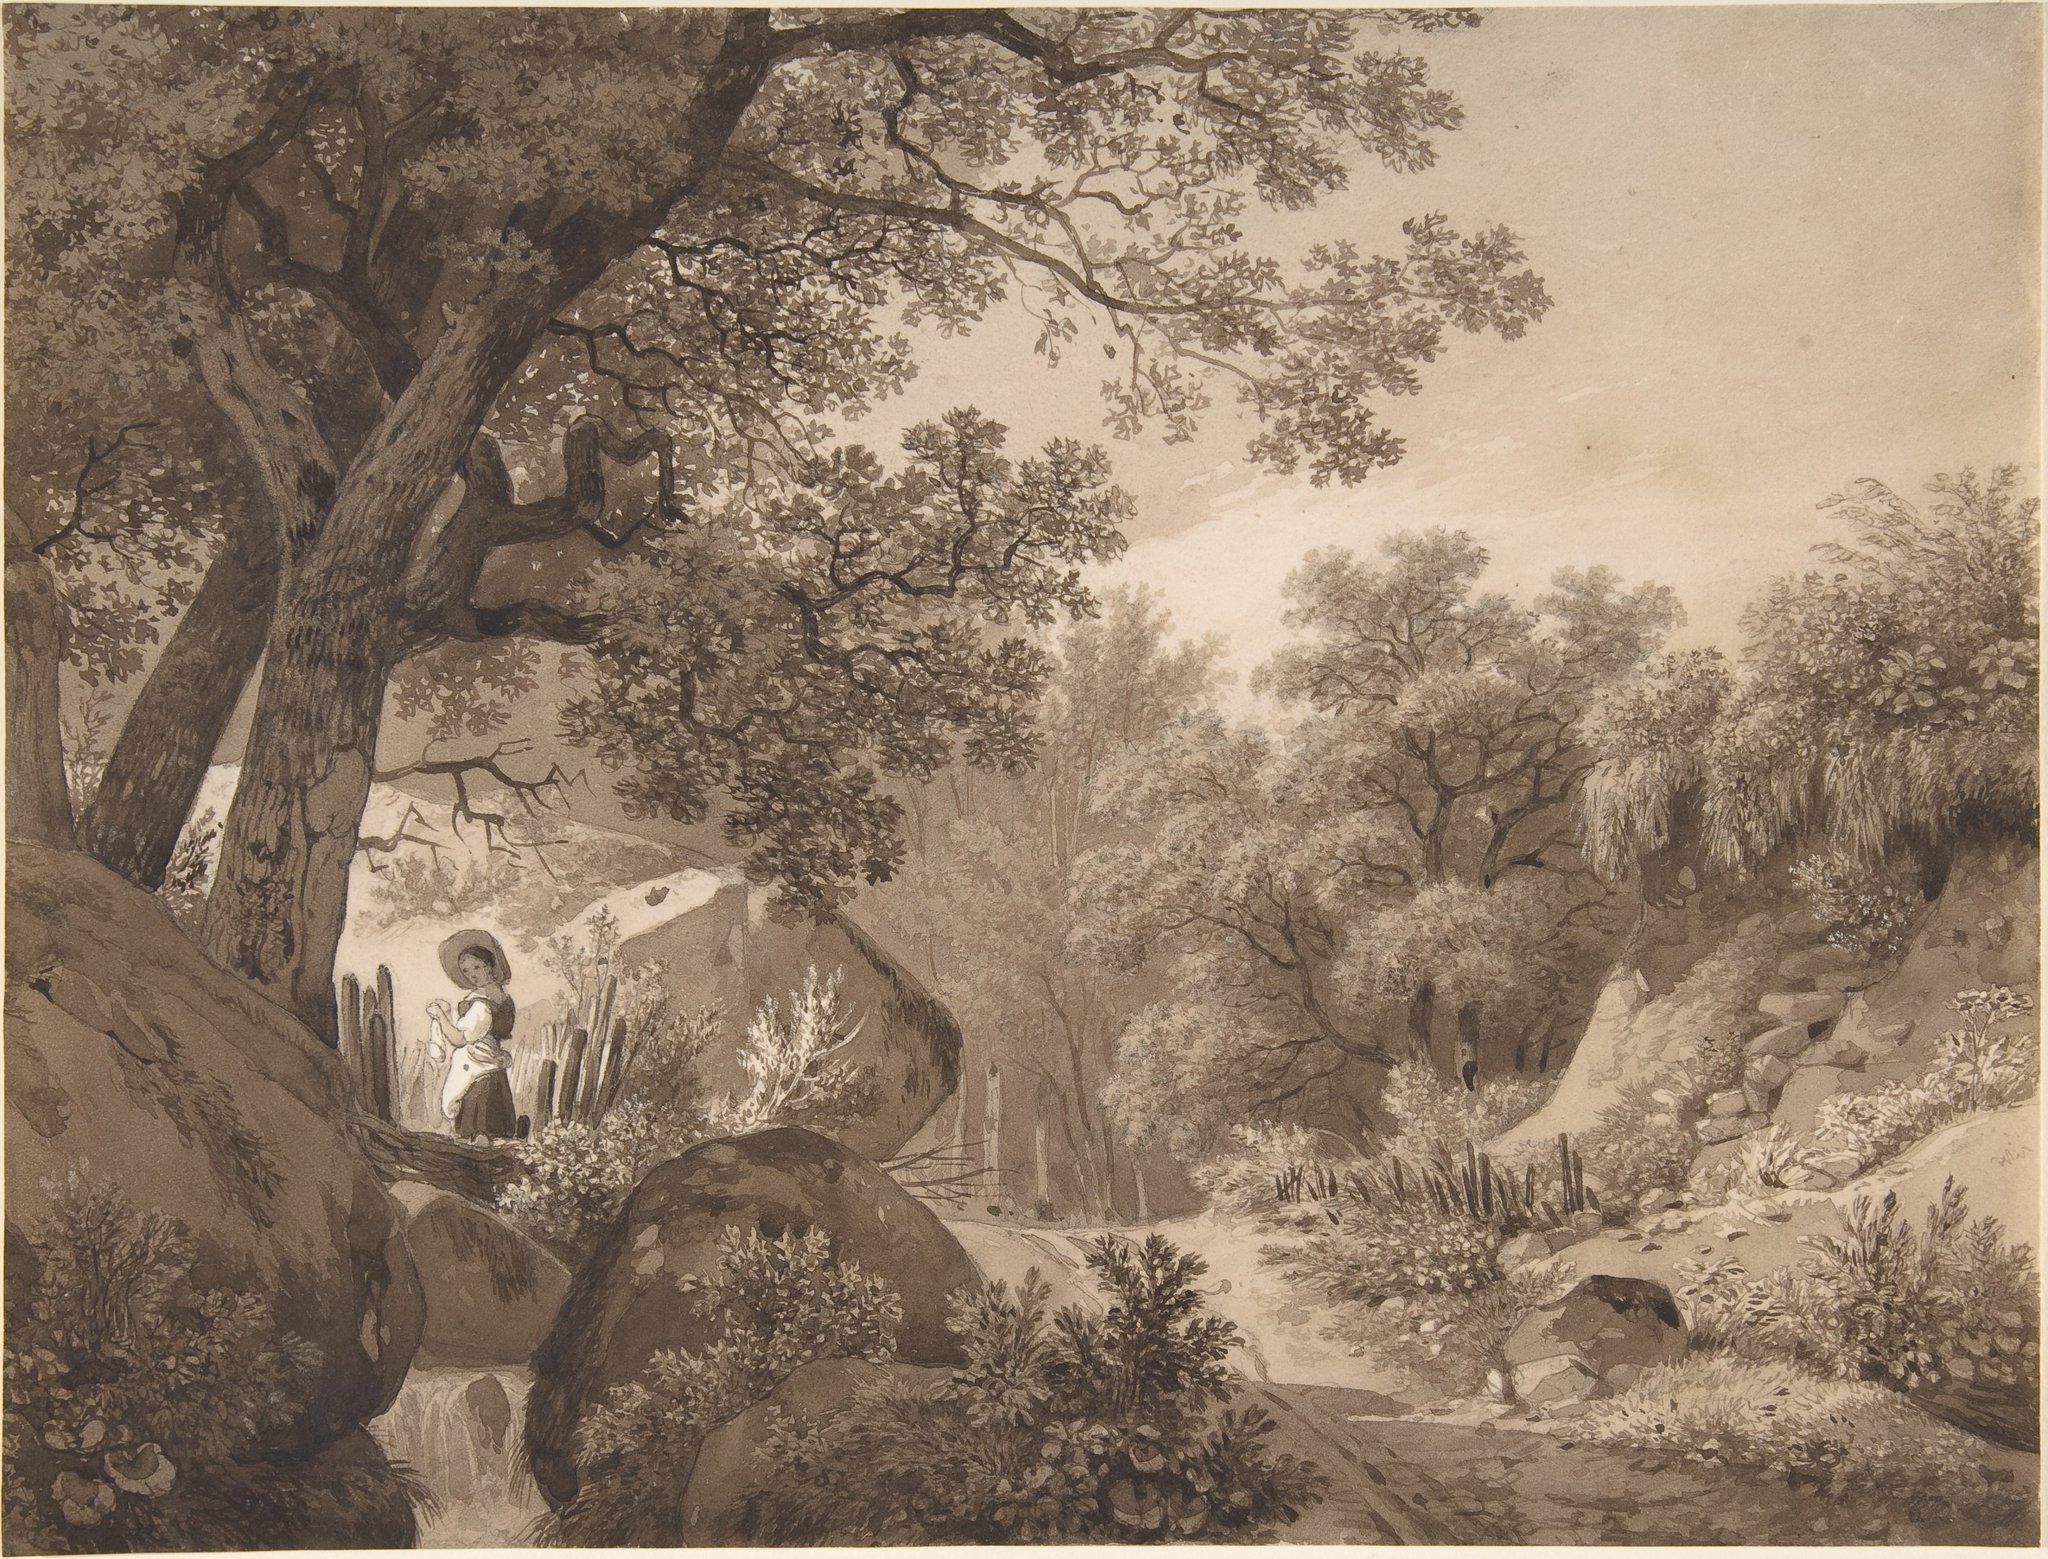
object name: drawing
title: Landscape with a Young Girl at a Waterfall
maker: wolfgang adam töpffer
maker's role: artist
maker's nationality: swiss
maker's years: 1766-1847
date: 1767-1900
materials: chalk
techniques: brush, wash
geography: switzerland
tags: girls,waterfalls,landscapes,trees